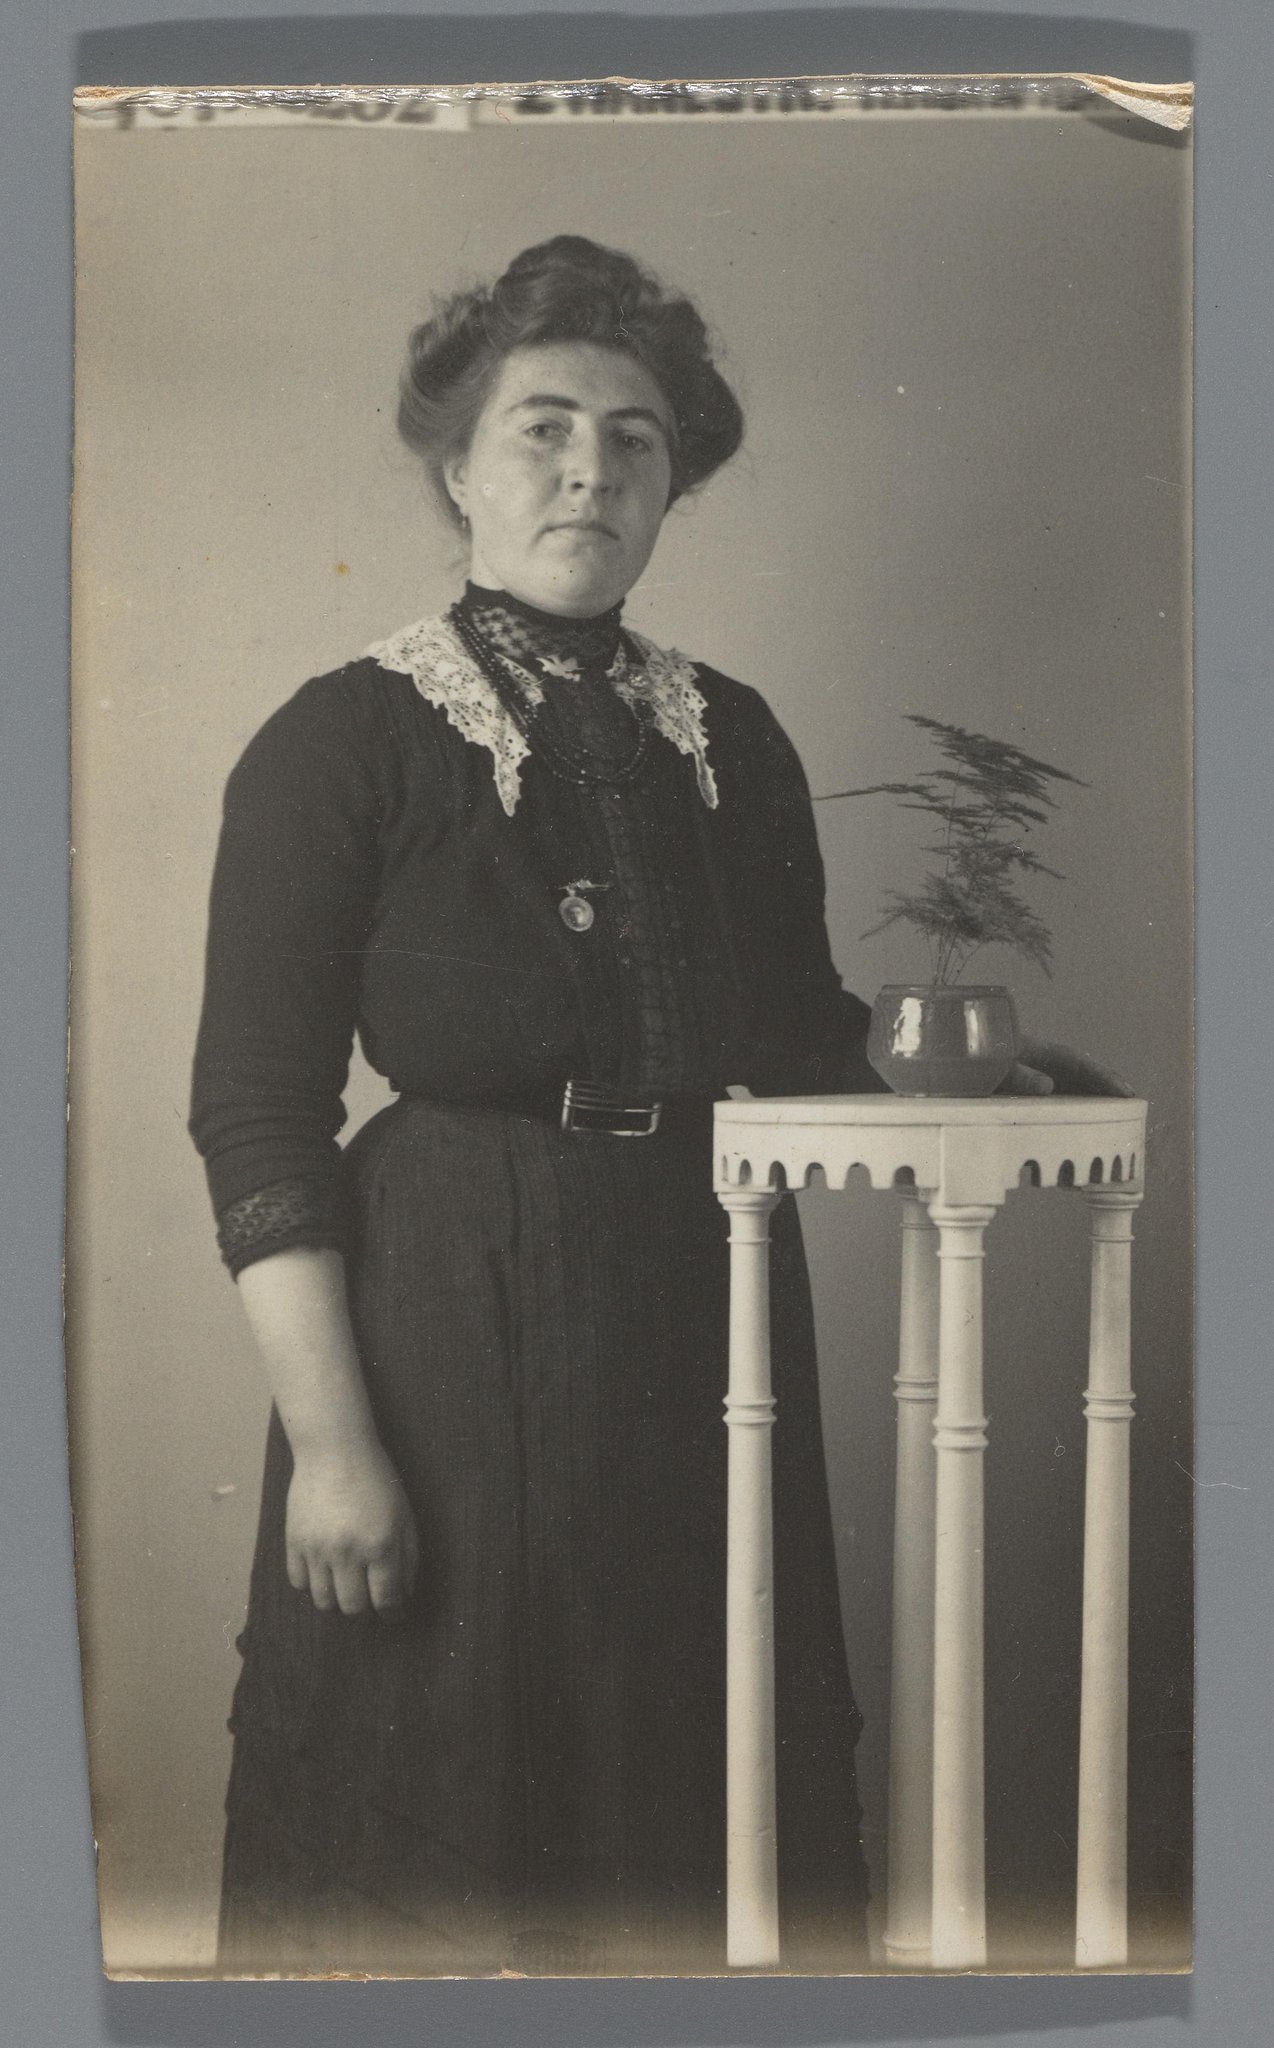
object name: snapshot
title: Portret van een vrouw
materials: photographic support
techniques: gelatin silver print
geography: groningen